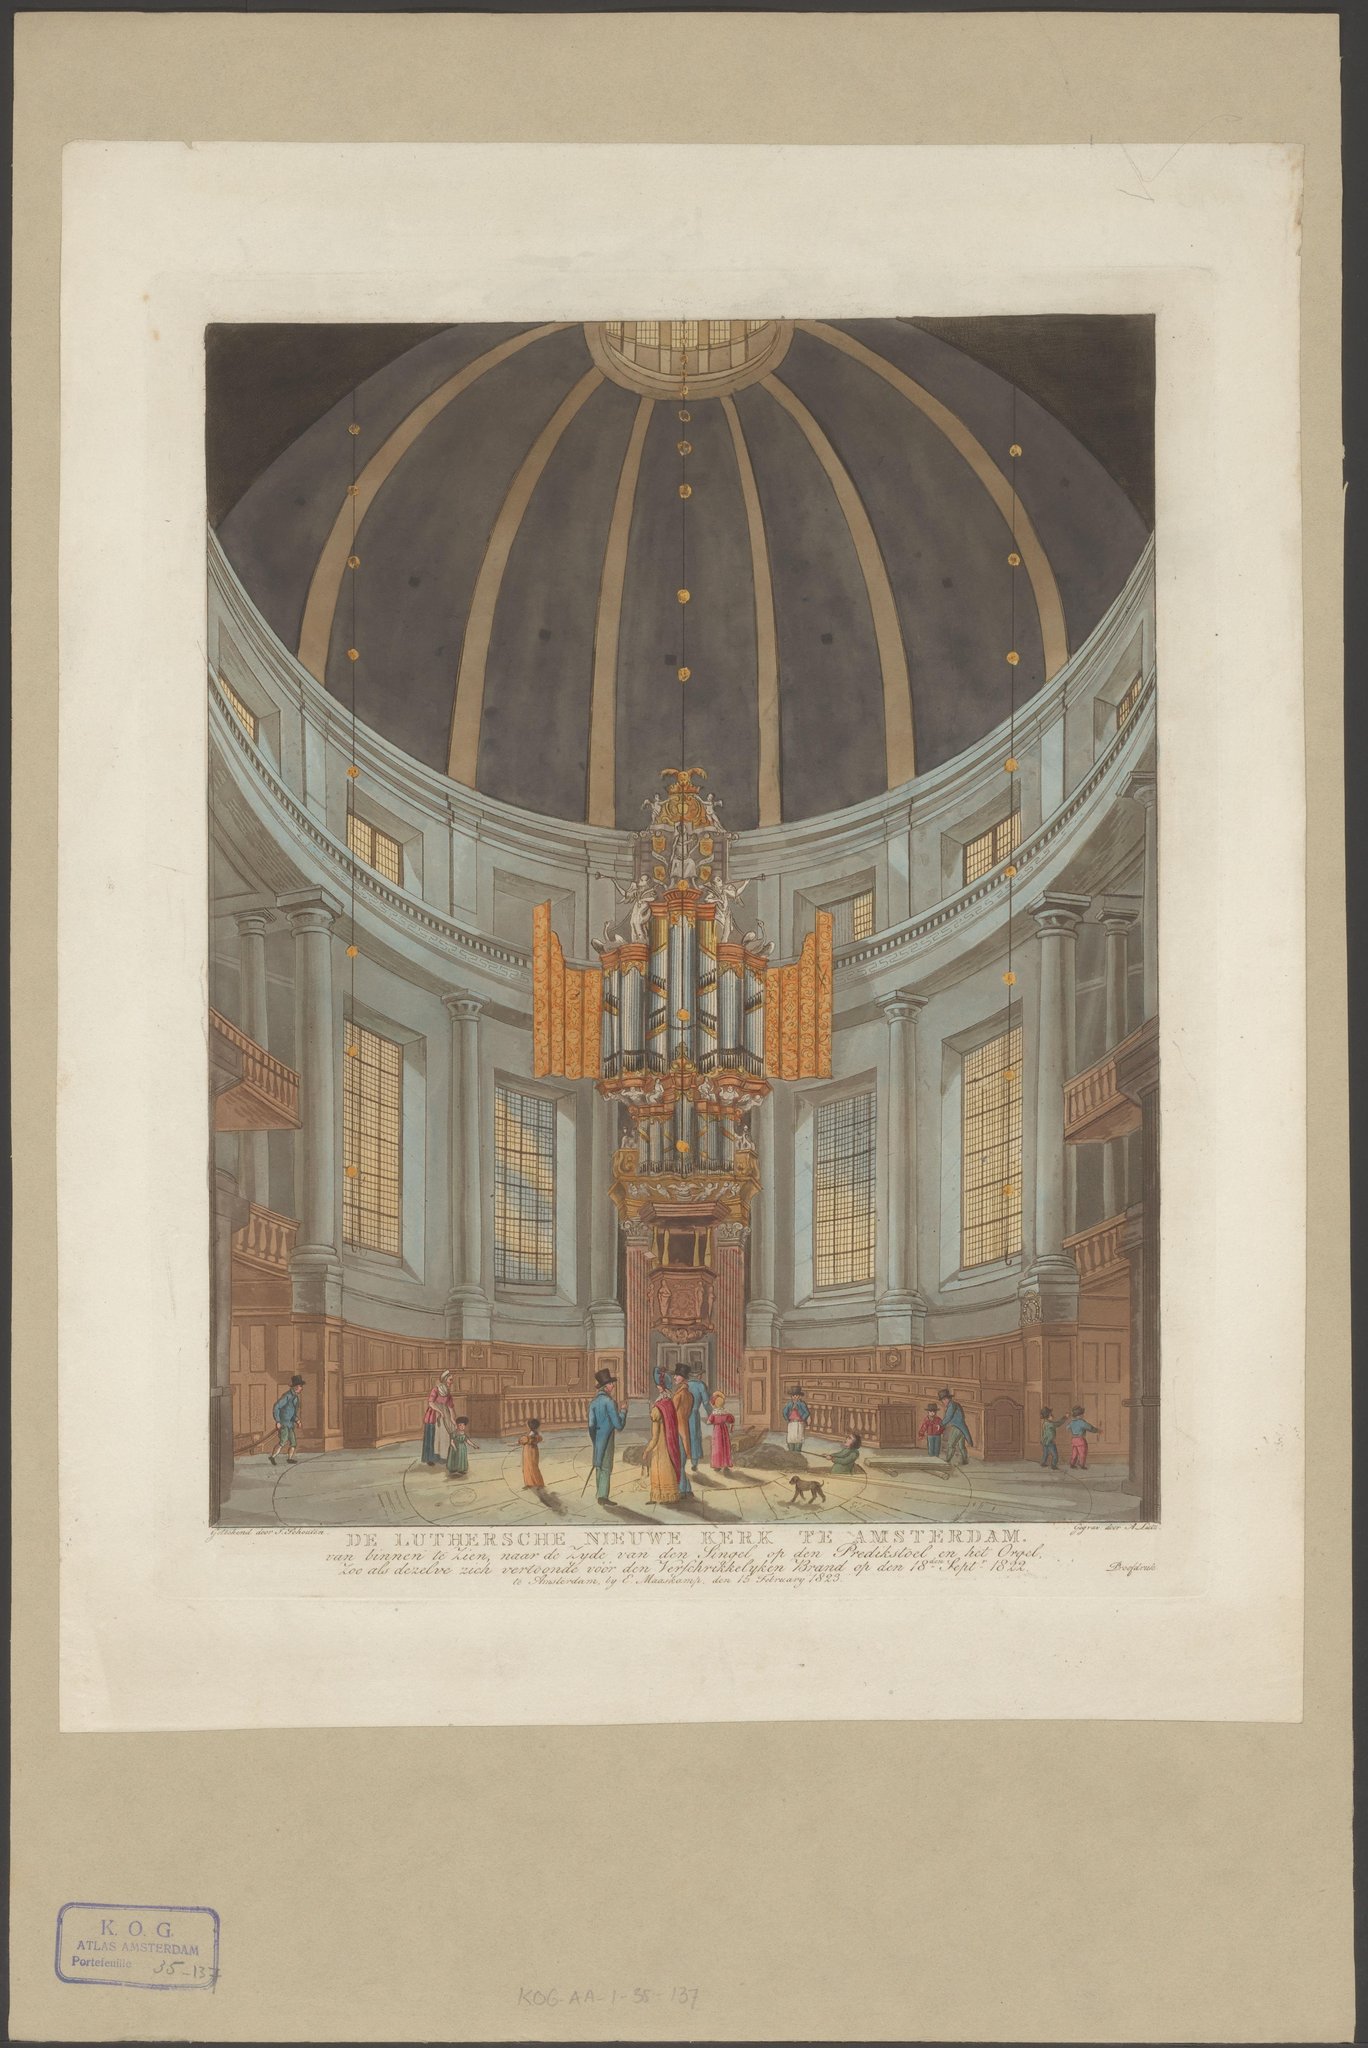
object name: print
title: Interieur van de Nieuwe Lutherse Kerk te Amsterdam, voor de brand van 1822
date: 1823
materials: paper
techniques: aquatint, etching, hand coloring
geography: amsterdam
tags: protestant churches and denominations (lutherans), parts of church interior: dome, church organ, grave digger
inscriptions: collector's mark: ‘35-137’ Lugt 1641b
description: Volgens Muller naar een oudere plaat uit: Nieuwe atlas, van de voornaamste gebouwen en gezigten der stad Amsterdam, met derzelver beknopte beschryvingen. 2 dln. Amsterdam: Daniël Jean Changuion en Petrus den Hengst [in opdracht van Pierre Fouquet], 1783, dl. 2.